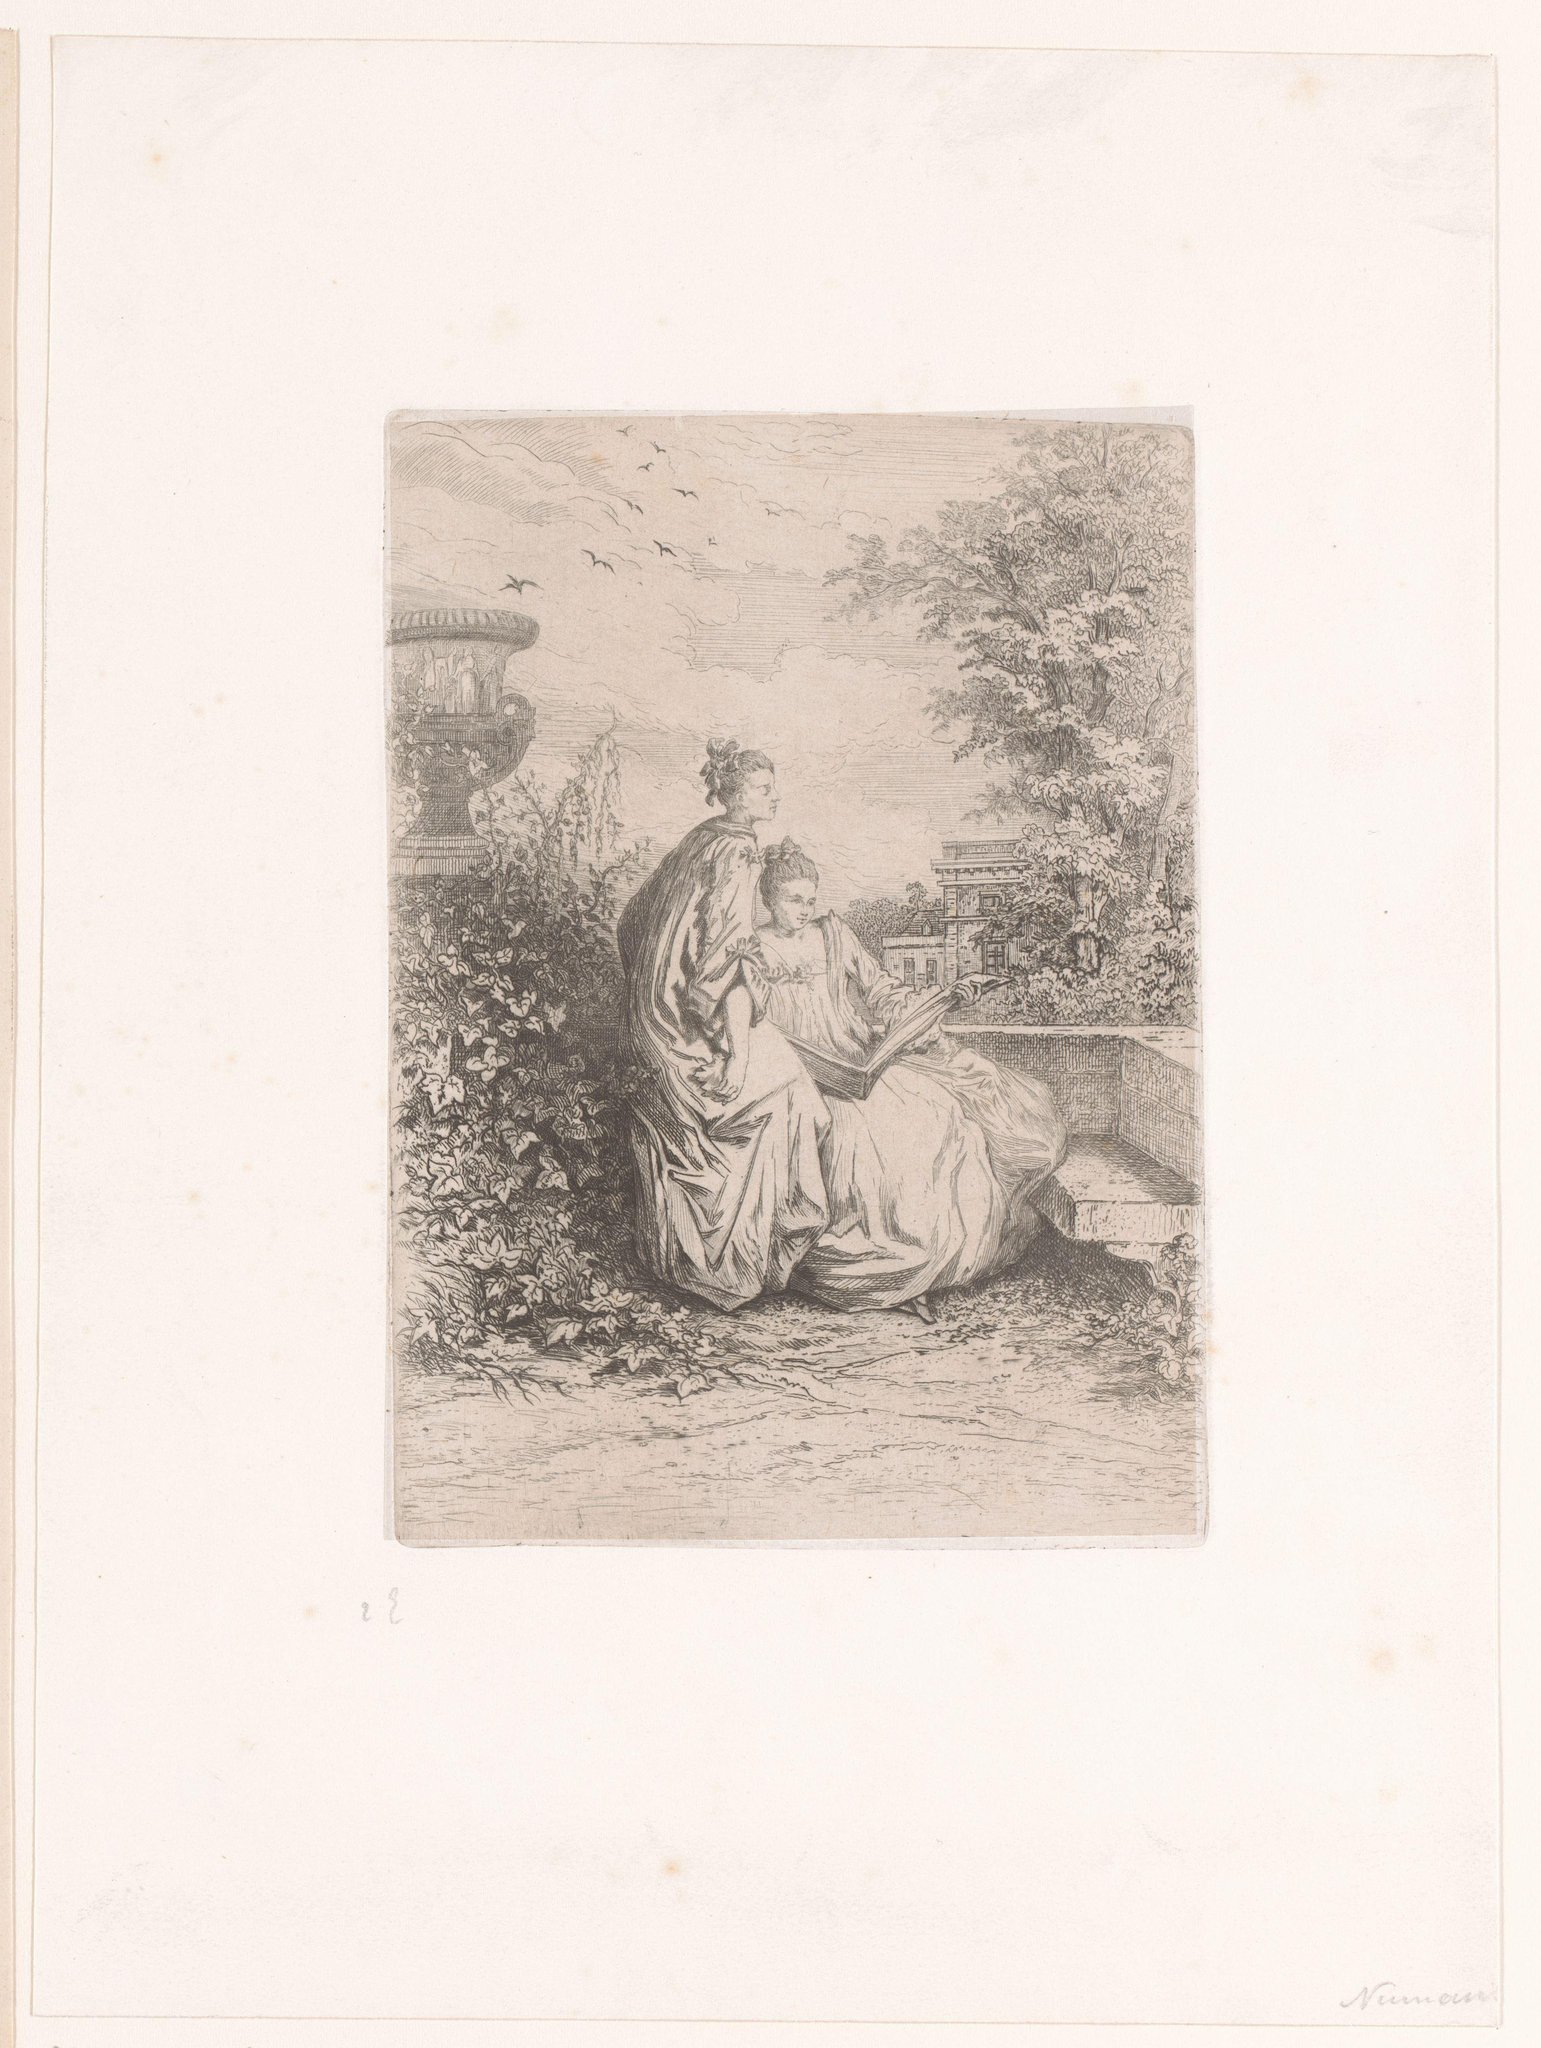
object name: print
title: Twee jonge vrouwen lezend op een buitenterras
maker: auguste numans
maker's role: print maker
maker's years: 1823-1883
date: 1833-1879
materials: paper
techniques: etching, intaglio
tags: reading, garden, adolescent, young woman, maiden (+ two persons)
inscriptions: collector's mark: Lugt 2228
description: De jonge vrouwen dragen een 'Watteau' model japon.